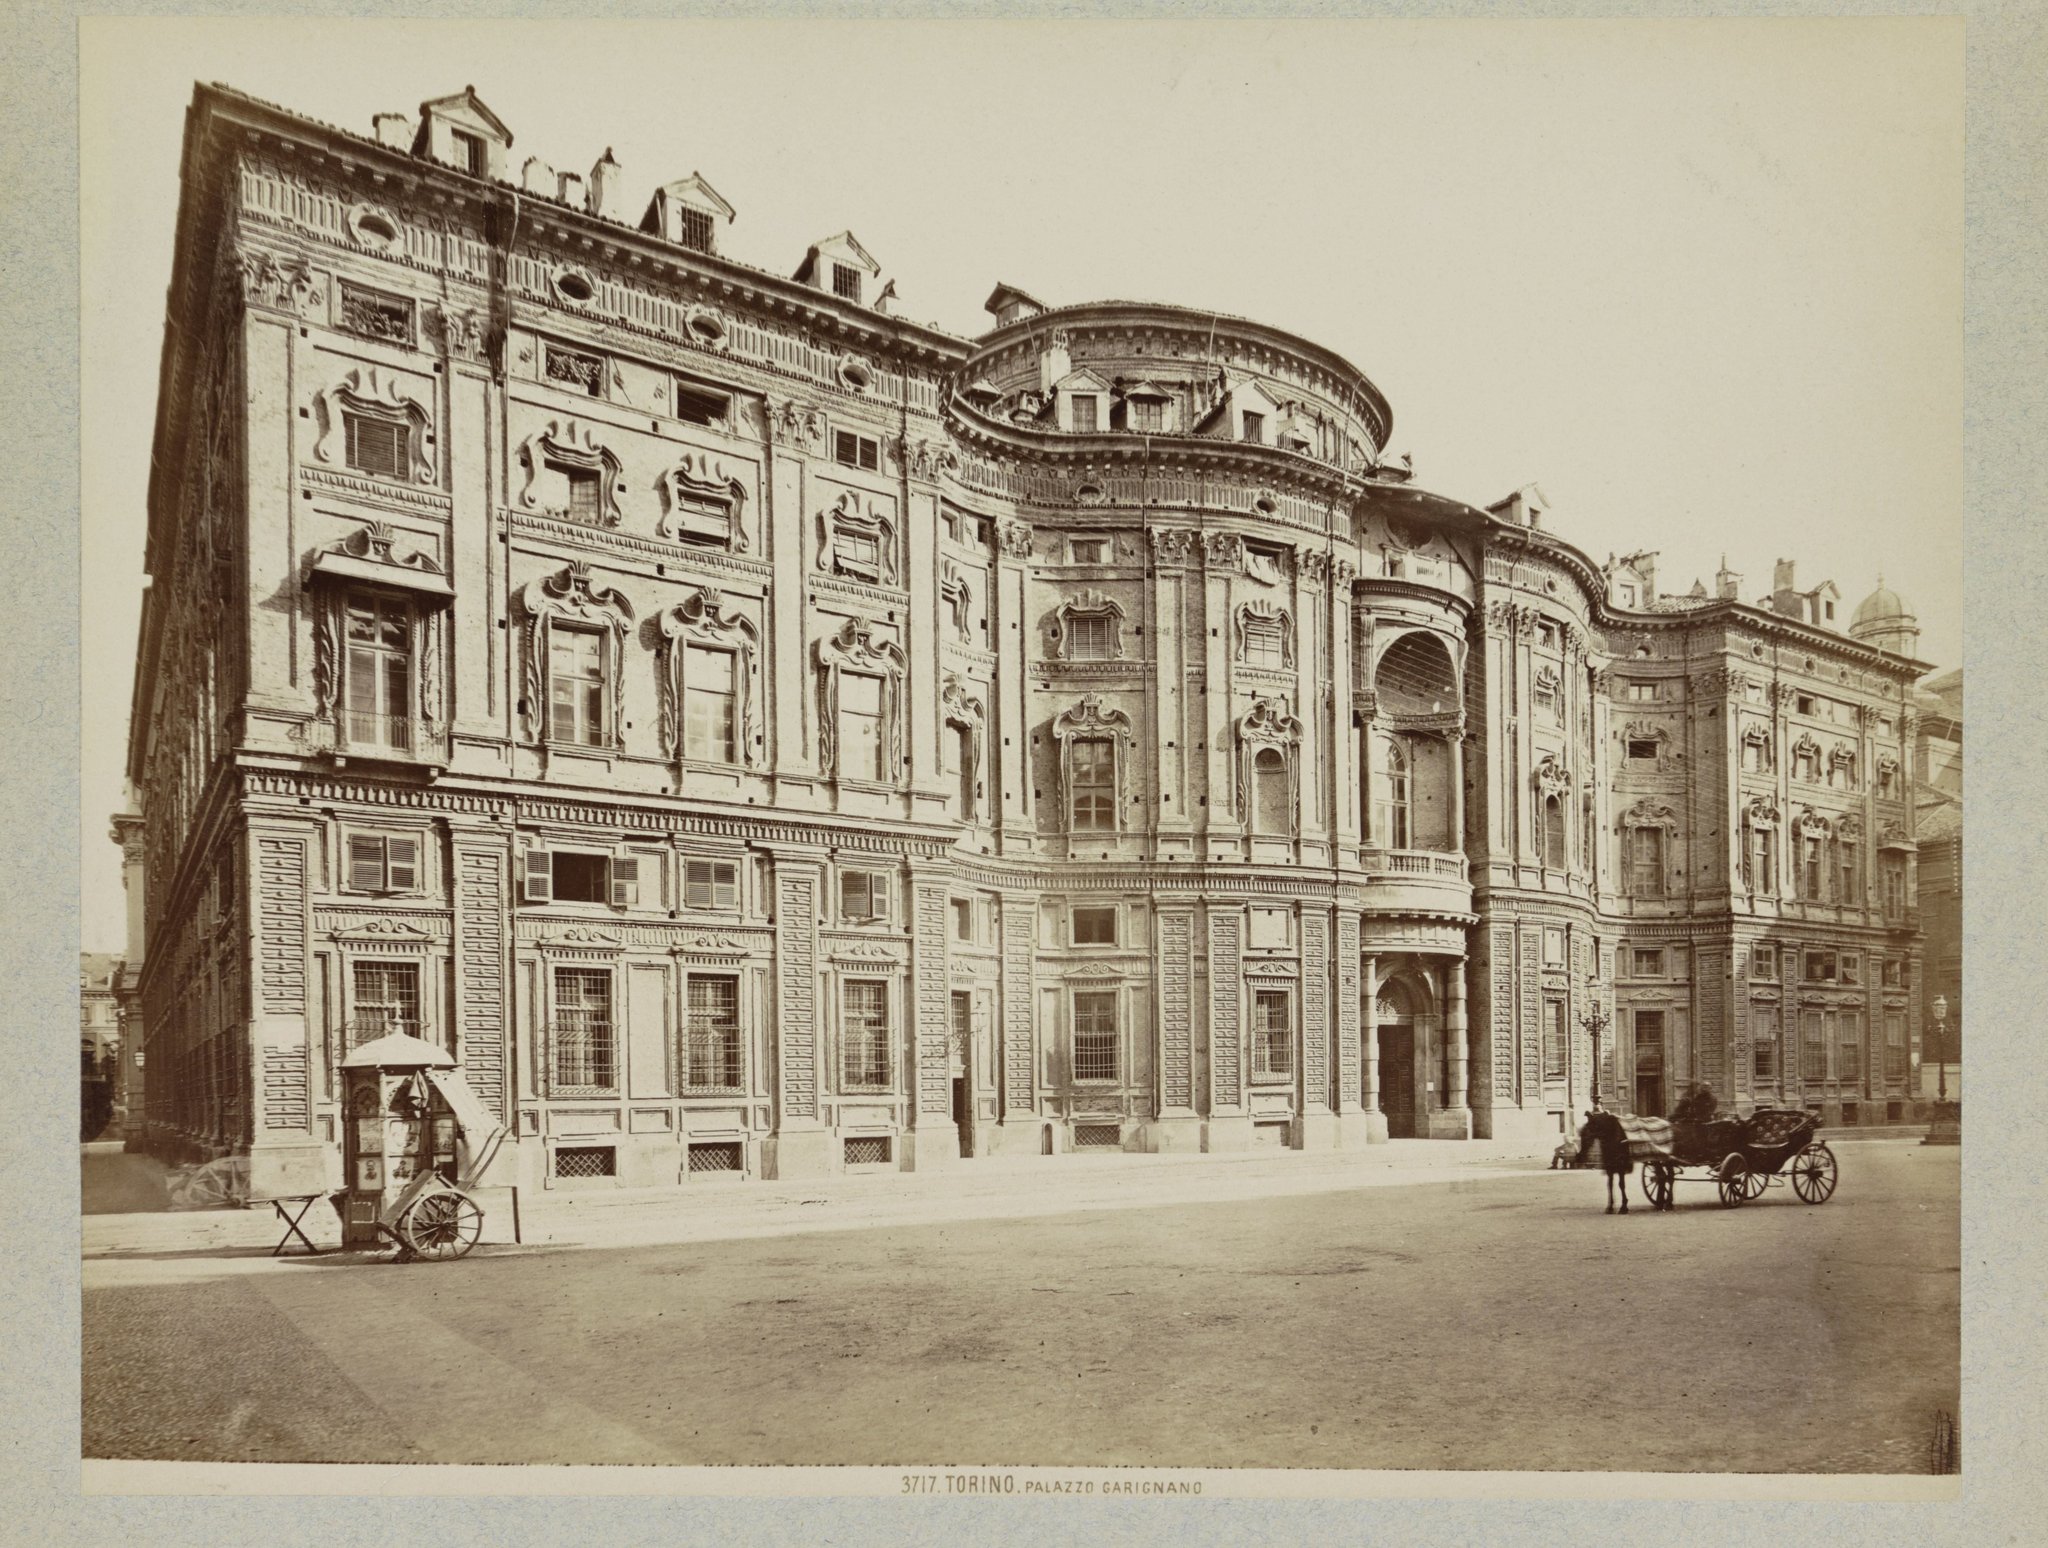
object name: photograph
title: Palazzo Carignano in Turijn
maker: Anonymous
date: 1885-1900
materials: paper, photographic support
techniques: albumen print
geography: france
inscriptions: caption: ‘3717 Torino Palazzo Carignano’